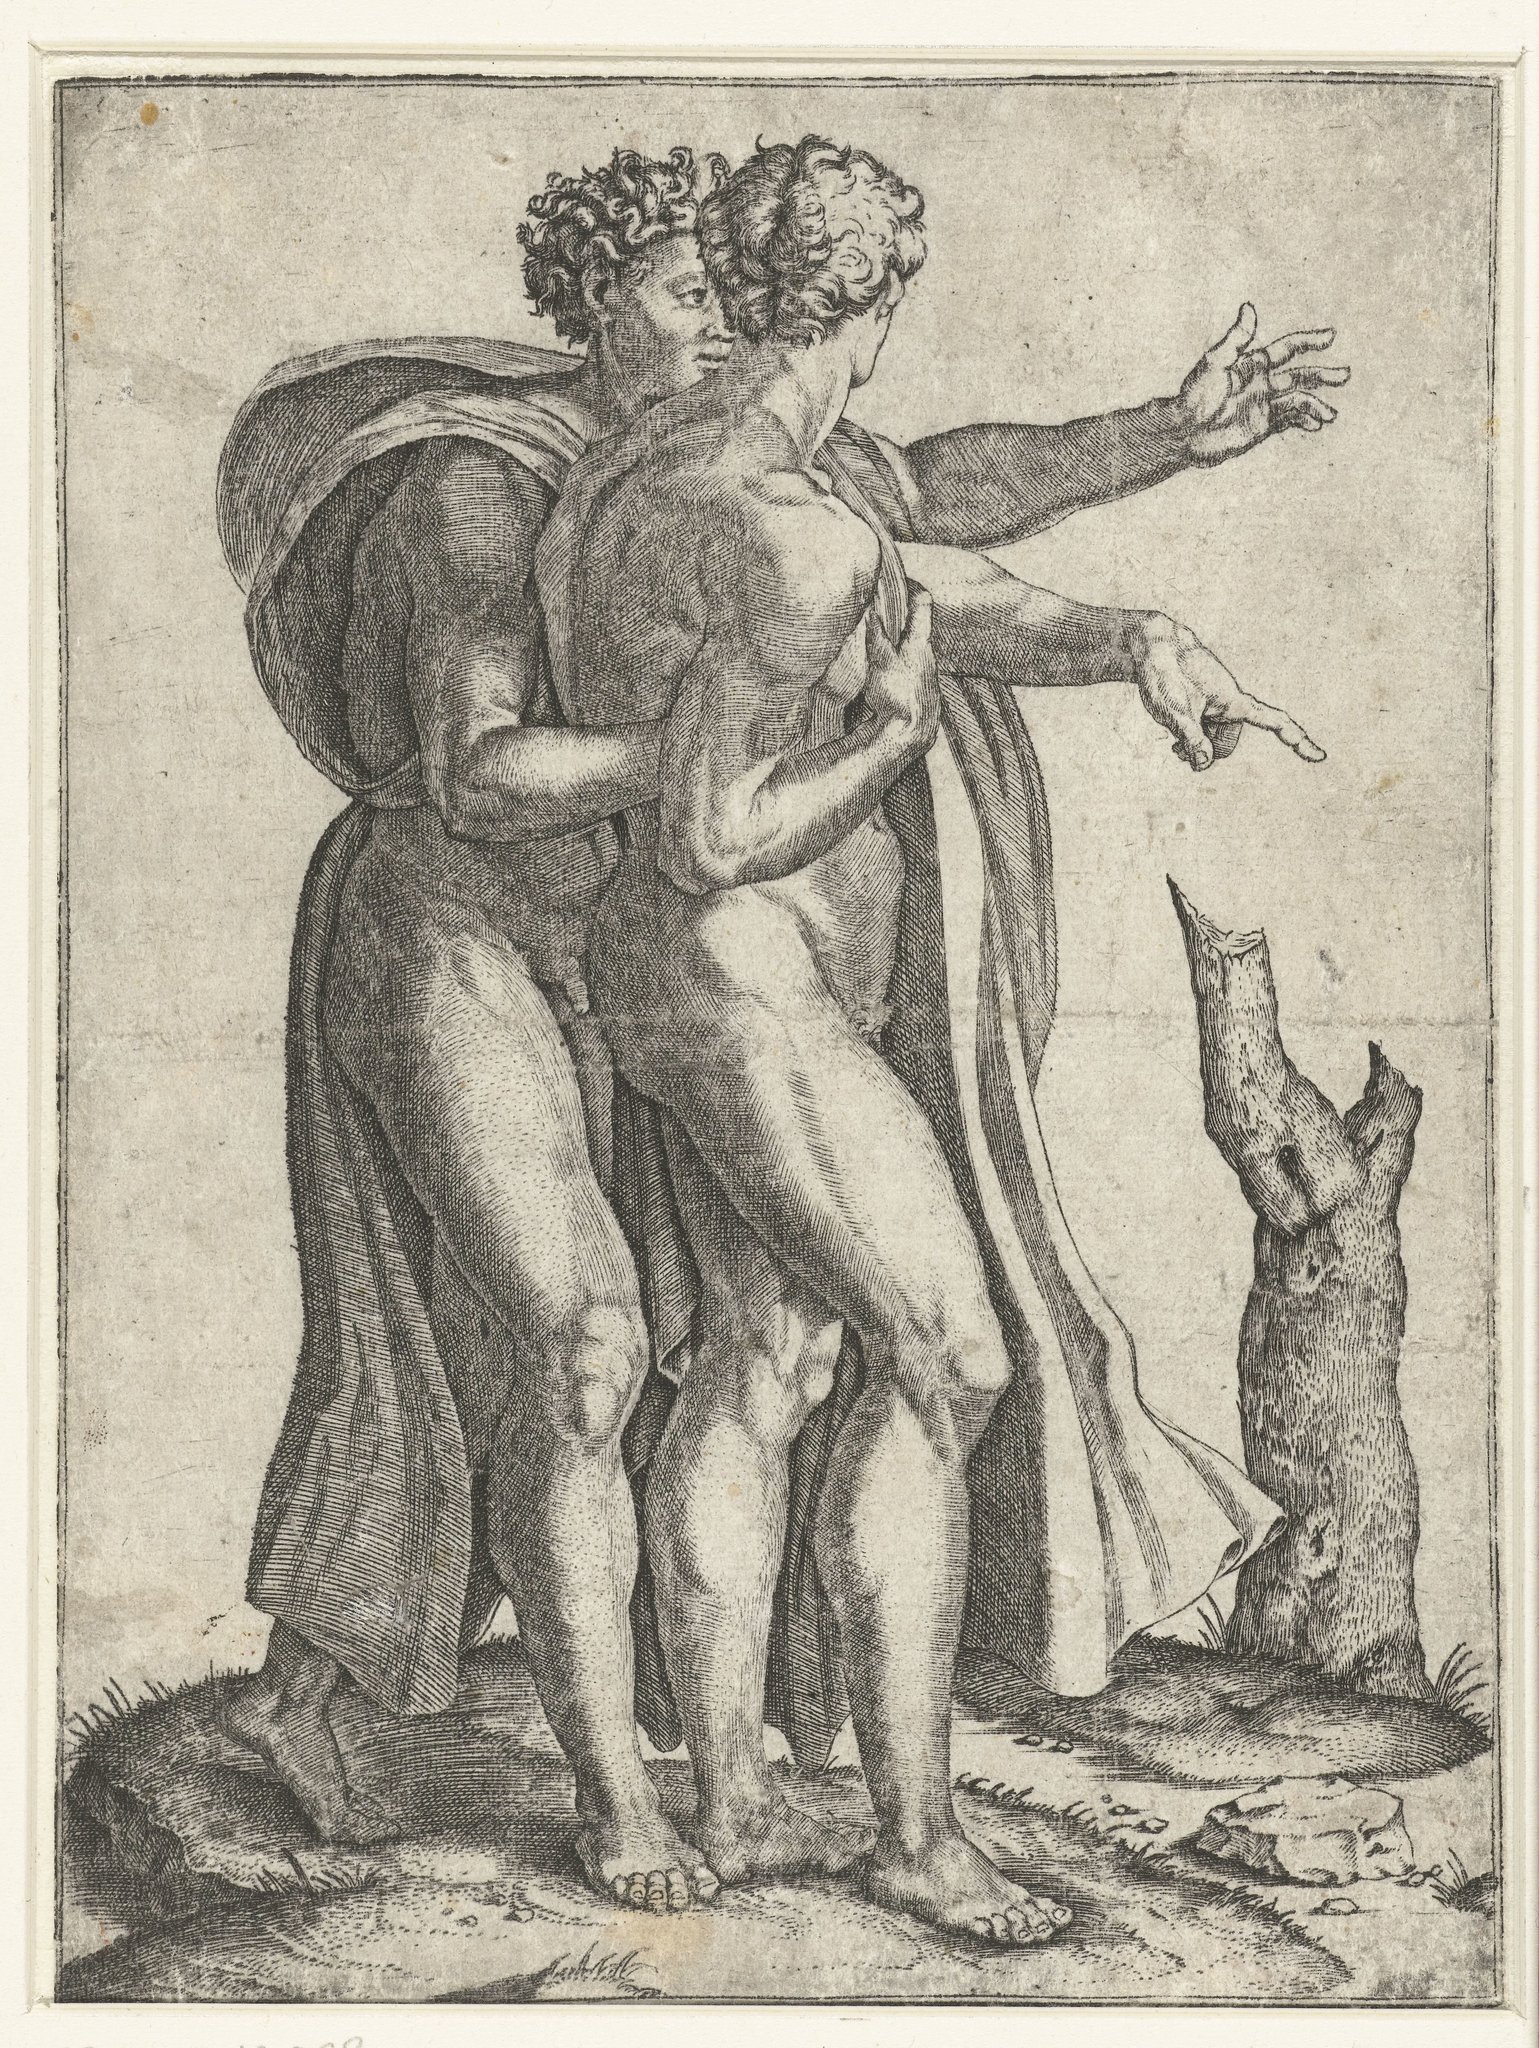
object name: print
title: Twee gebarende naakte mannen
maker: marcantonio raimondi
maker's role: print maker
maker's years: 1470-1534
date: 1510-1527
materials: paper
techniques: engraving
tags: the (nude) human figure; 'corpo humano' (ripa), male sex; man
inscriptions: collector's mark: Lugt 12